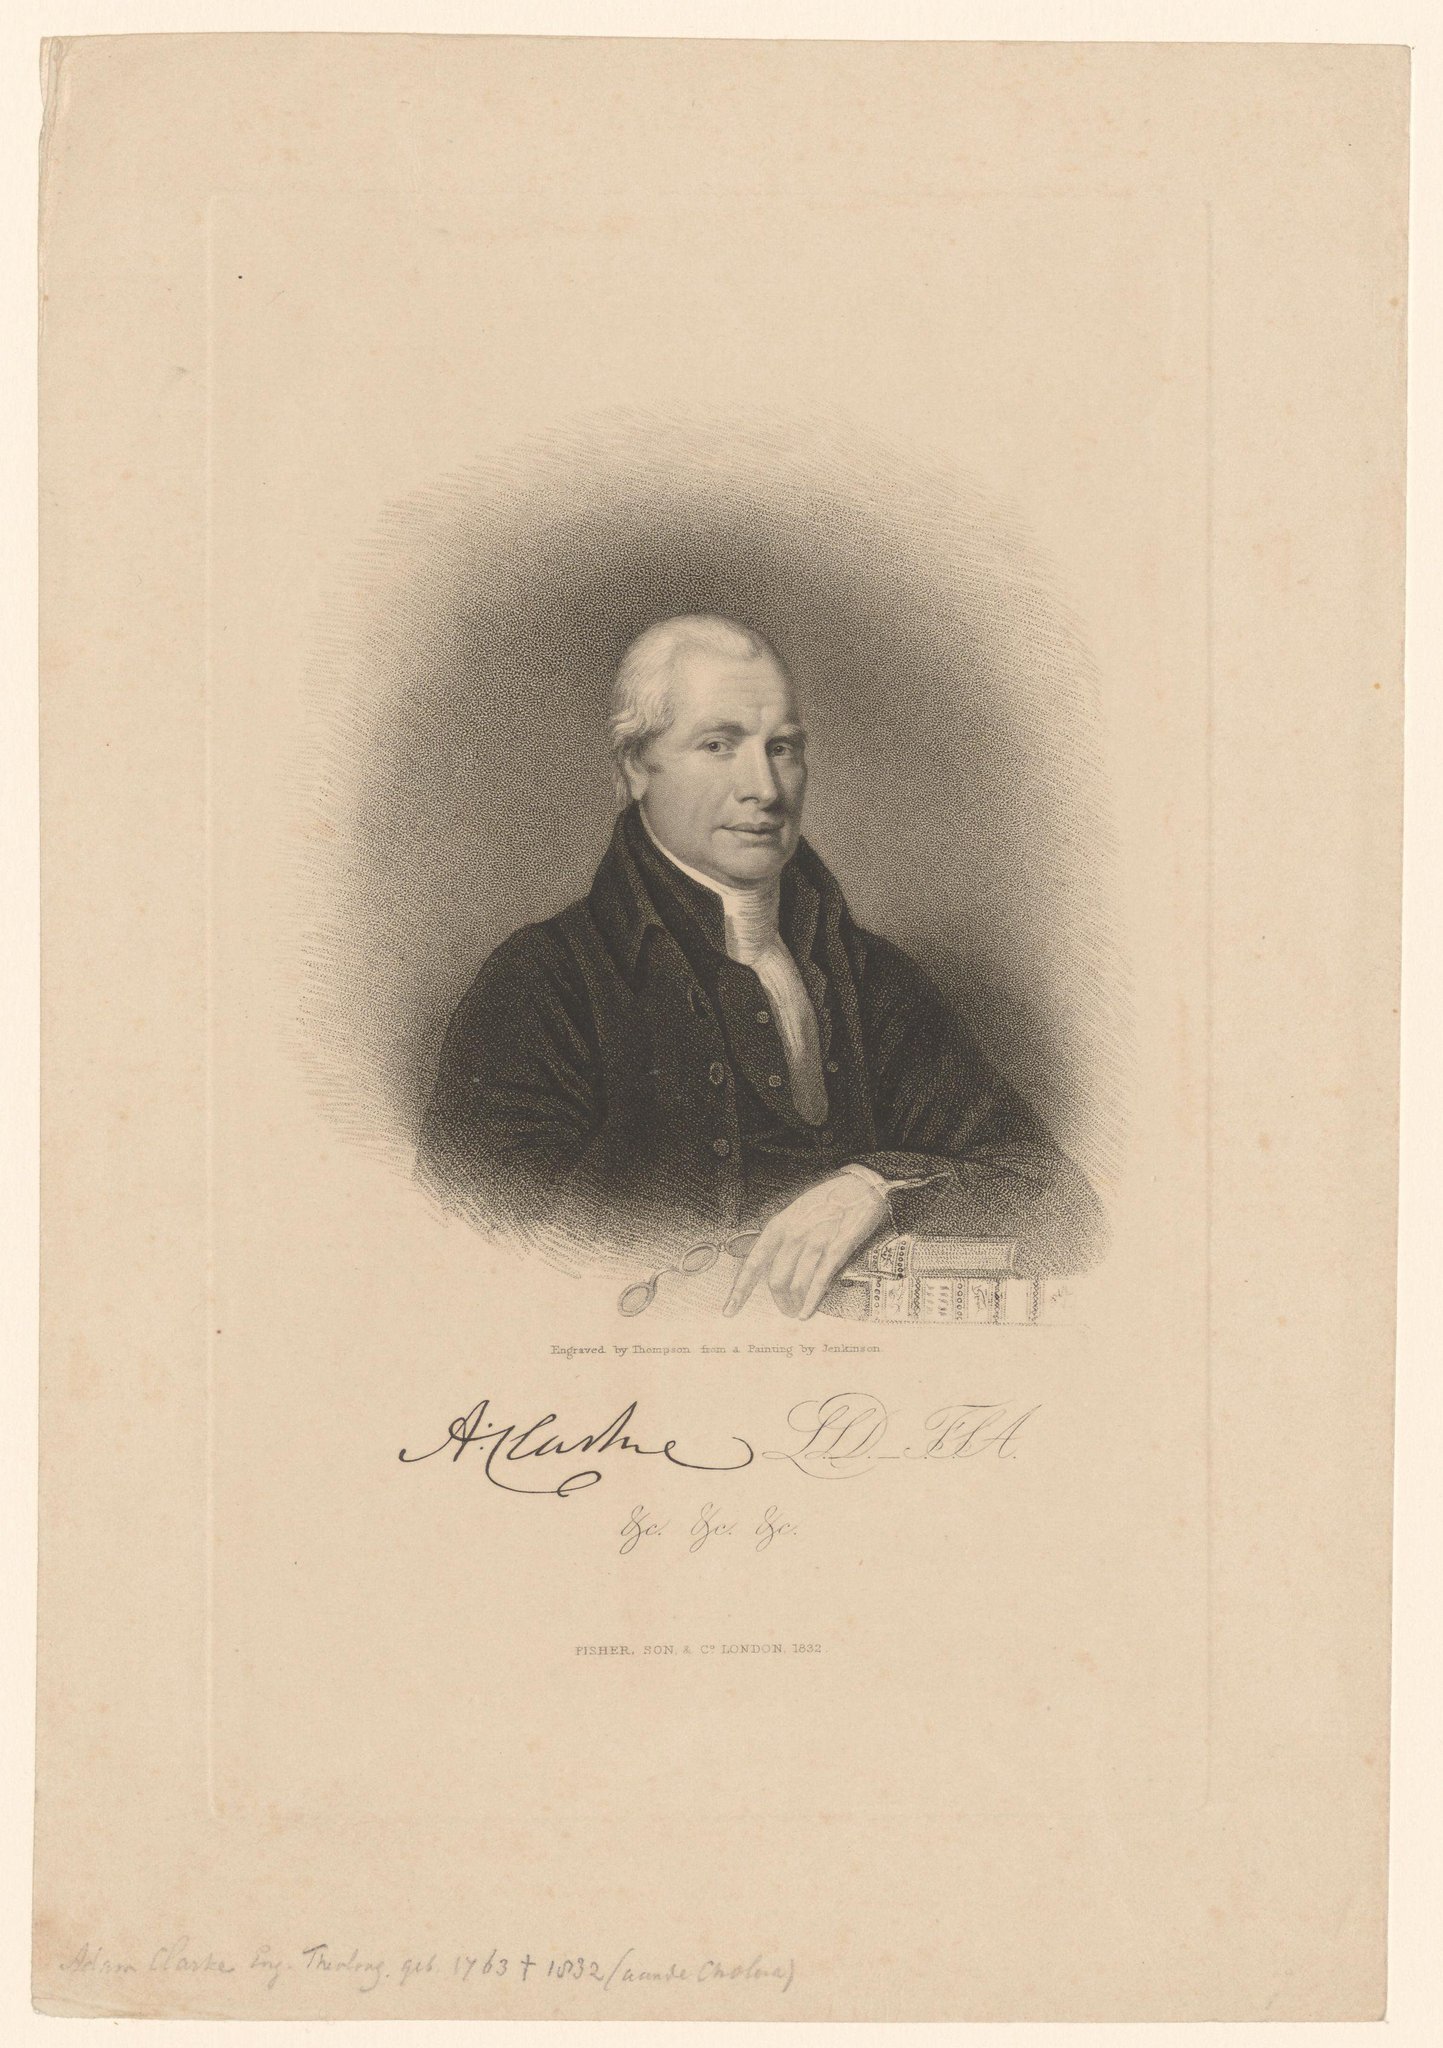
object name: print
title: A: Clarke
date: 1823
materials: paper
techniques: roulette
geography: london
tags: theologian, historical persons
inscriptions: collector's mark: Lugt 2228